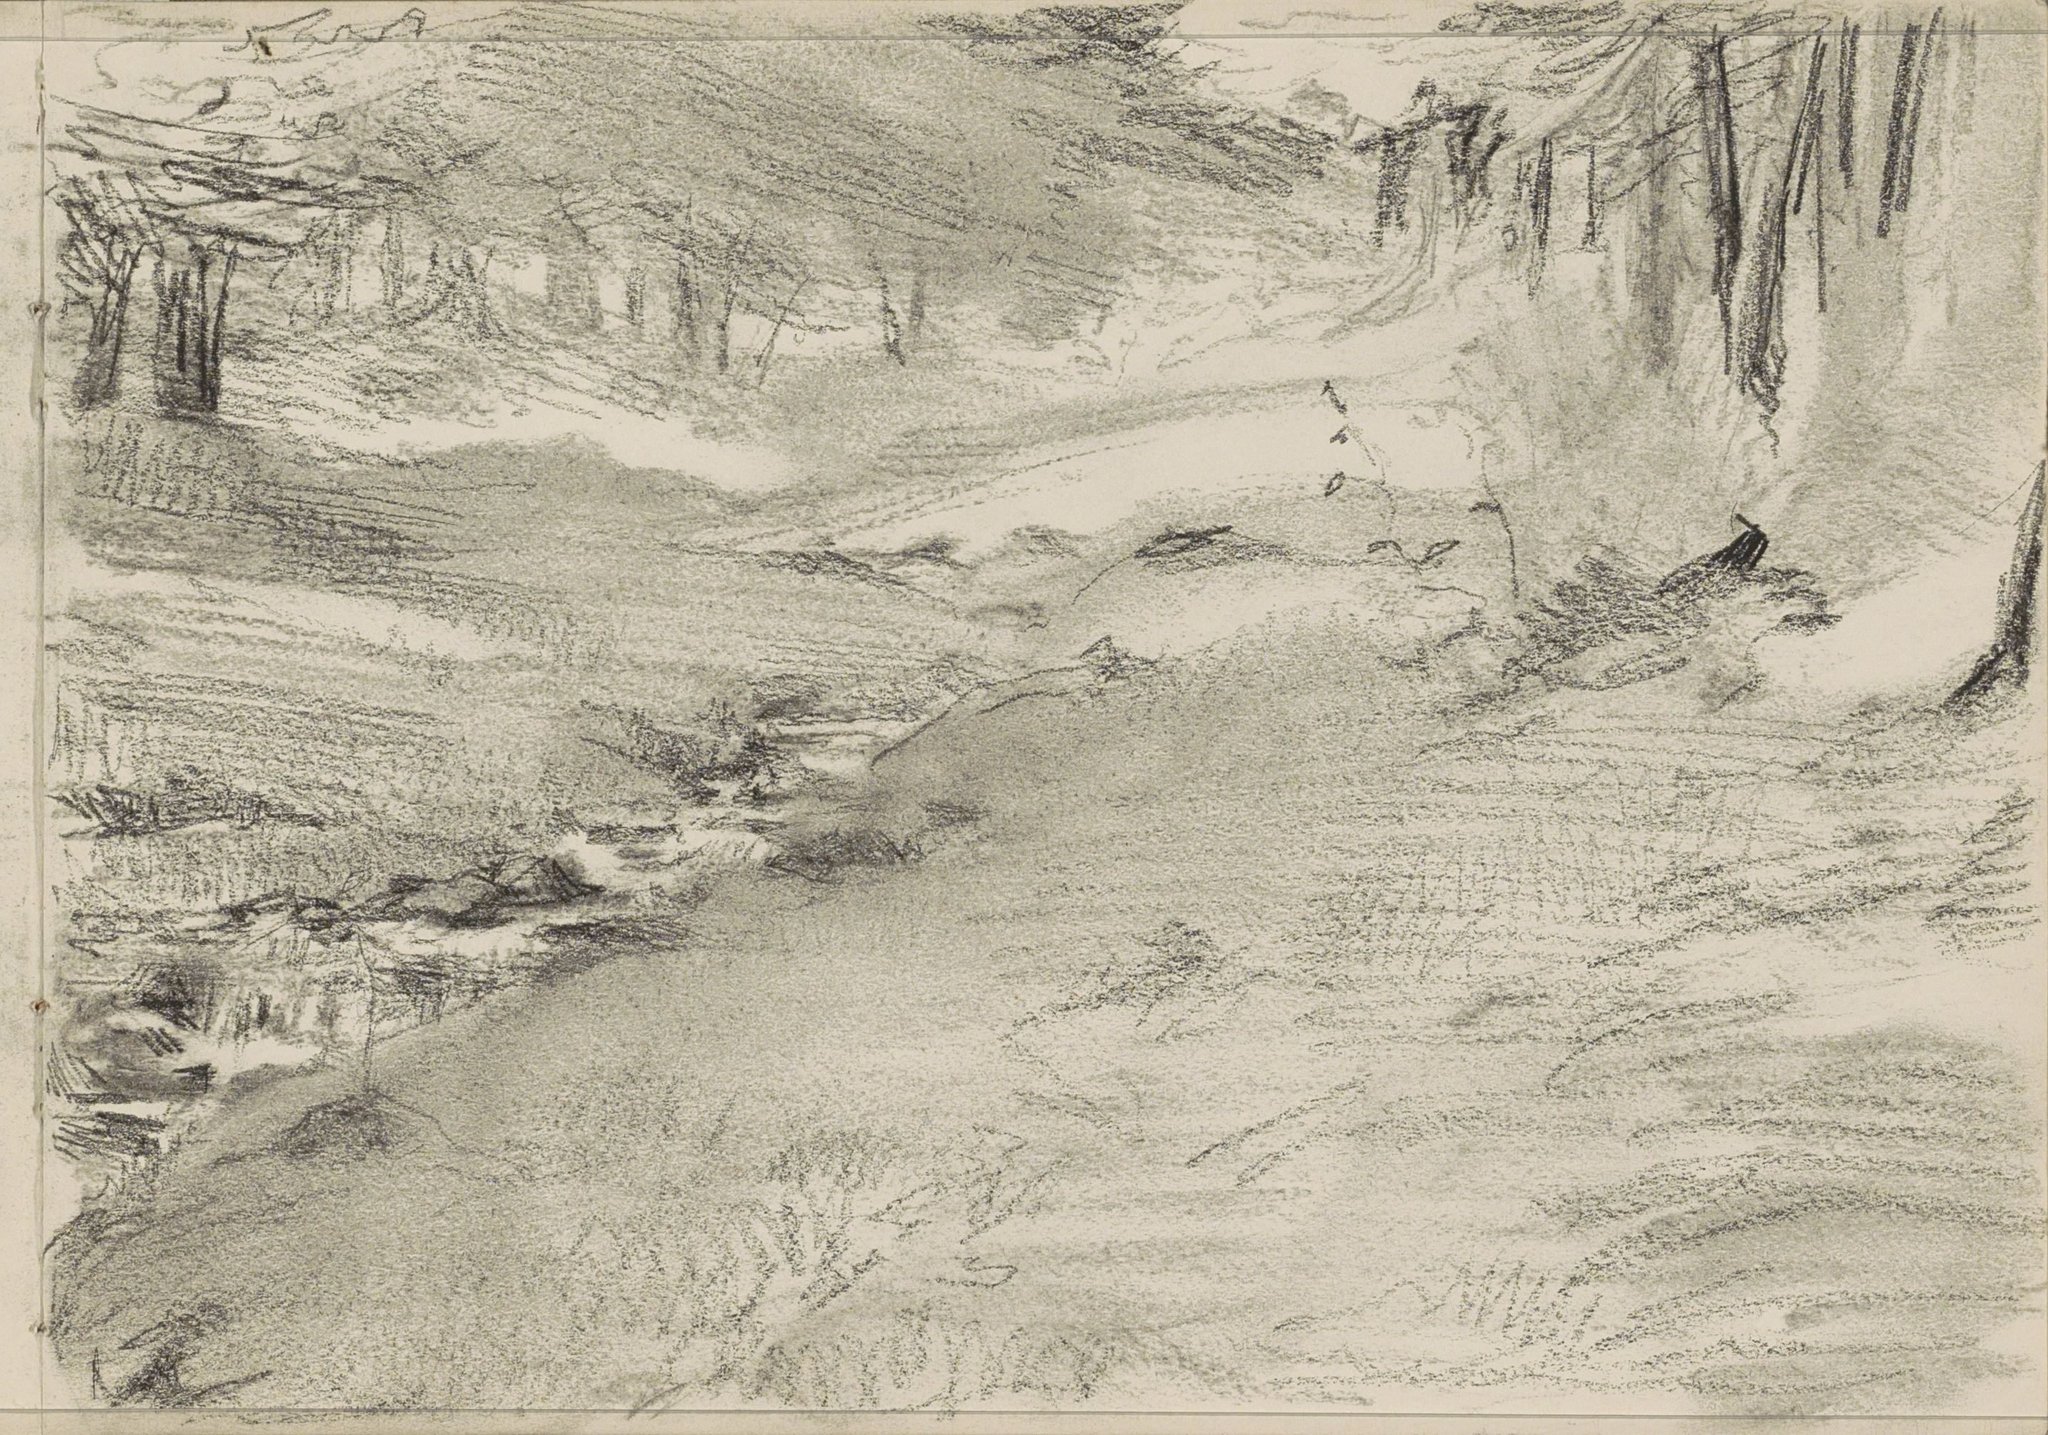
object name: sketchbook leaf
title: Beek in een bos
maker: a.a.l. de grammont-hubrecht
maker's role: draughtsman, painter, print maker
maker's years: 1855-1913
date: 1865-1913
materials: chalk, paper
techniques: stumping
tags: forest, wood, brook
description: Blad 63 recto uit een schetsboek met 68 bladen.